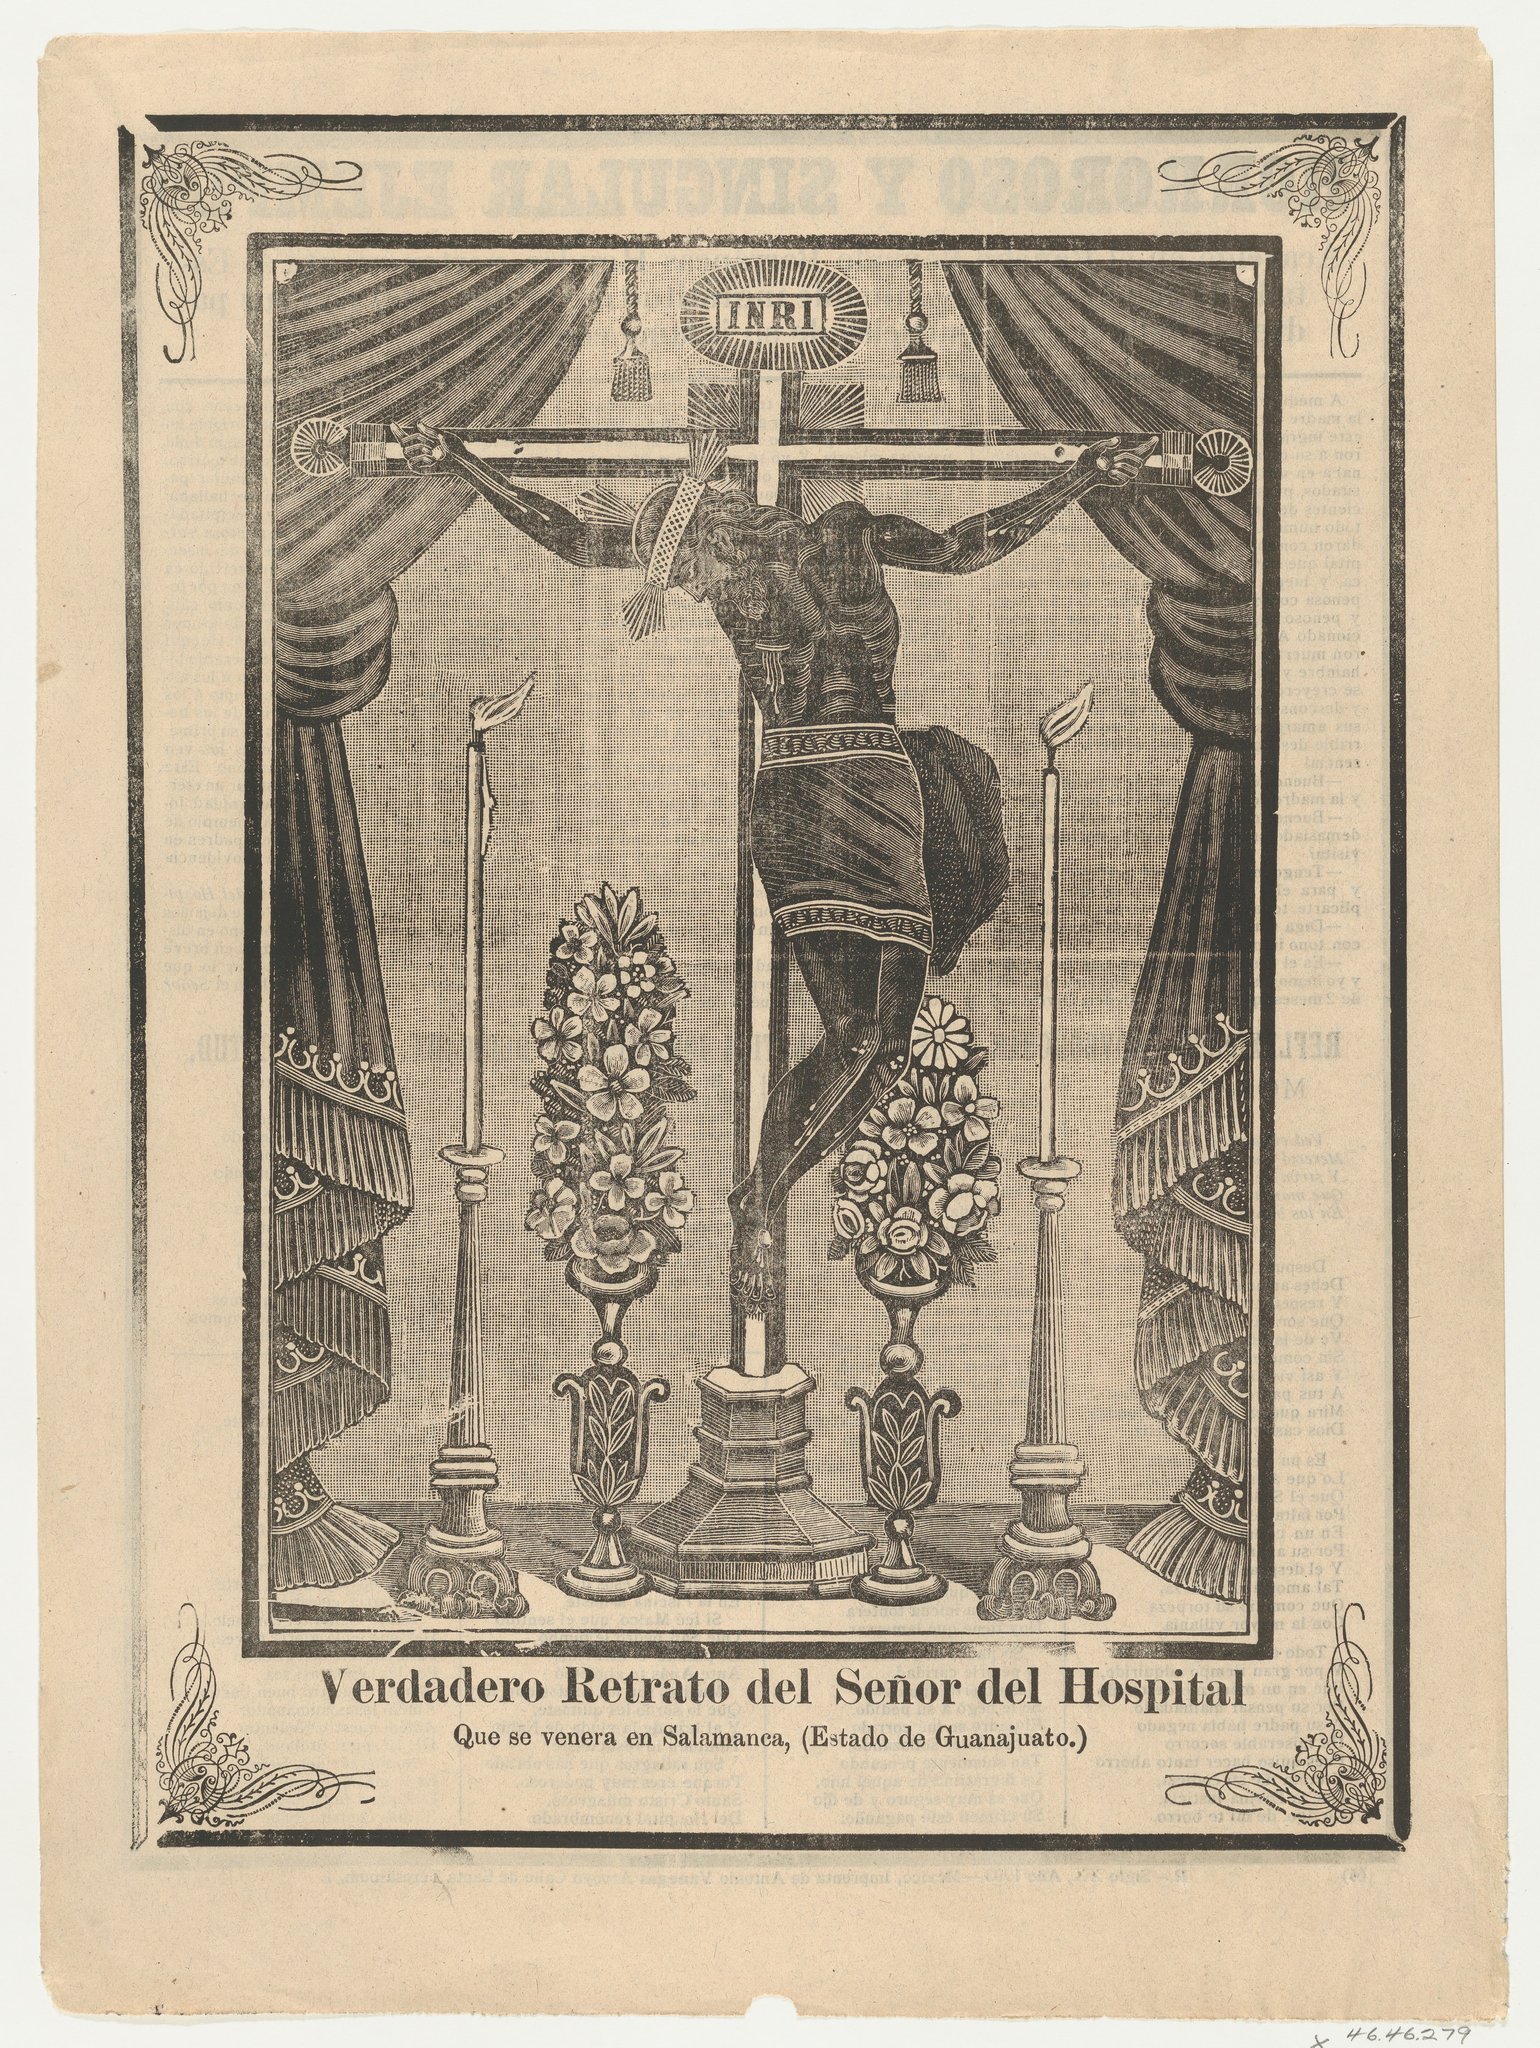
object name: print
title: Broadsheet relating to Our Lord of the Hospital (Salamanca, Guanajuato) on a crucifix on an altar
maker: Anonymous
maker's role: artist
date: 1903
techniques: letterpress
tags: christ,cross,crucifixion